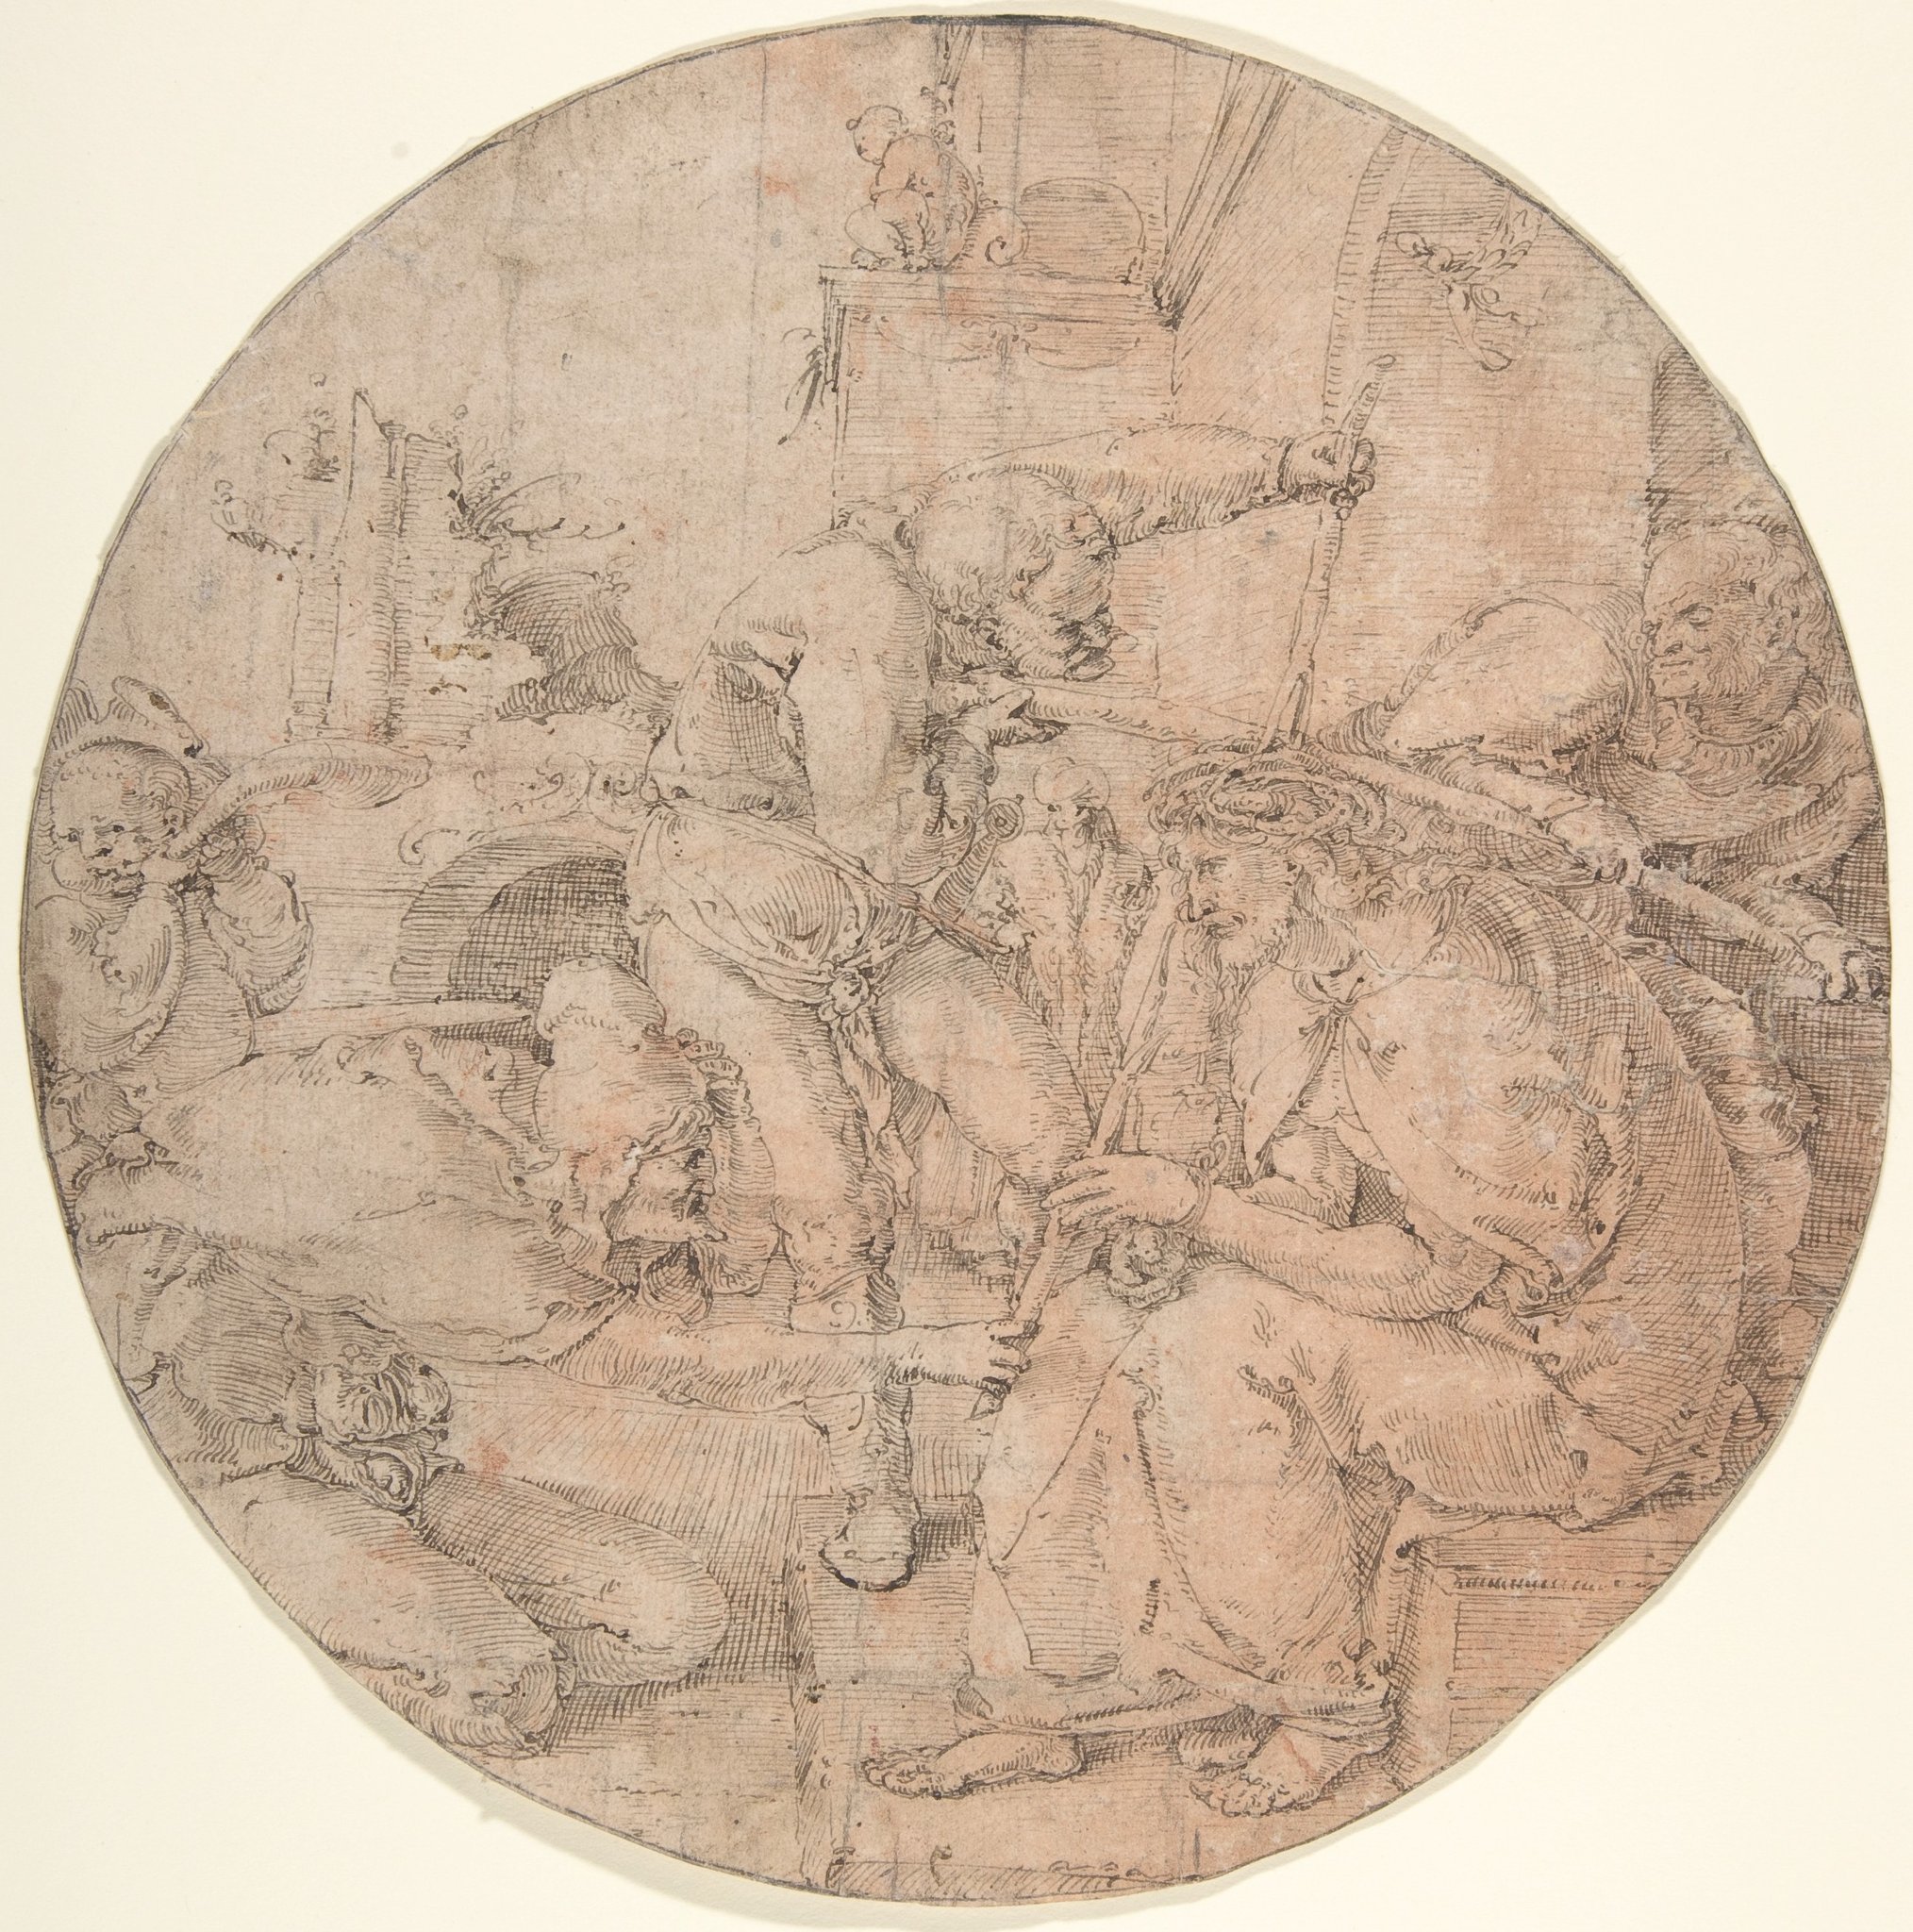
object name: drawing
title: The Crowning with Thorns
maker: lucas van leyden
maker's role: artist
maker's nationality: netherlandish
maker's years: 1494-1533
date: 1520-1530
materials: ink, paper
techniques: pen, wash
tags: men,christ